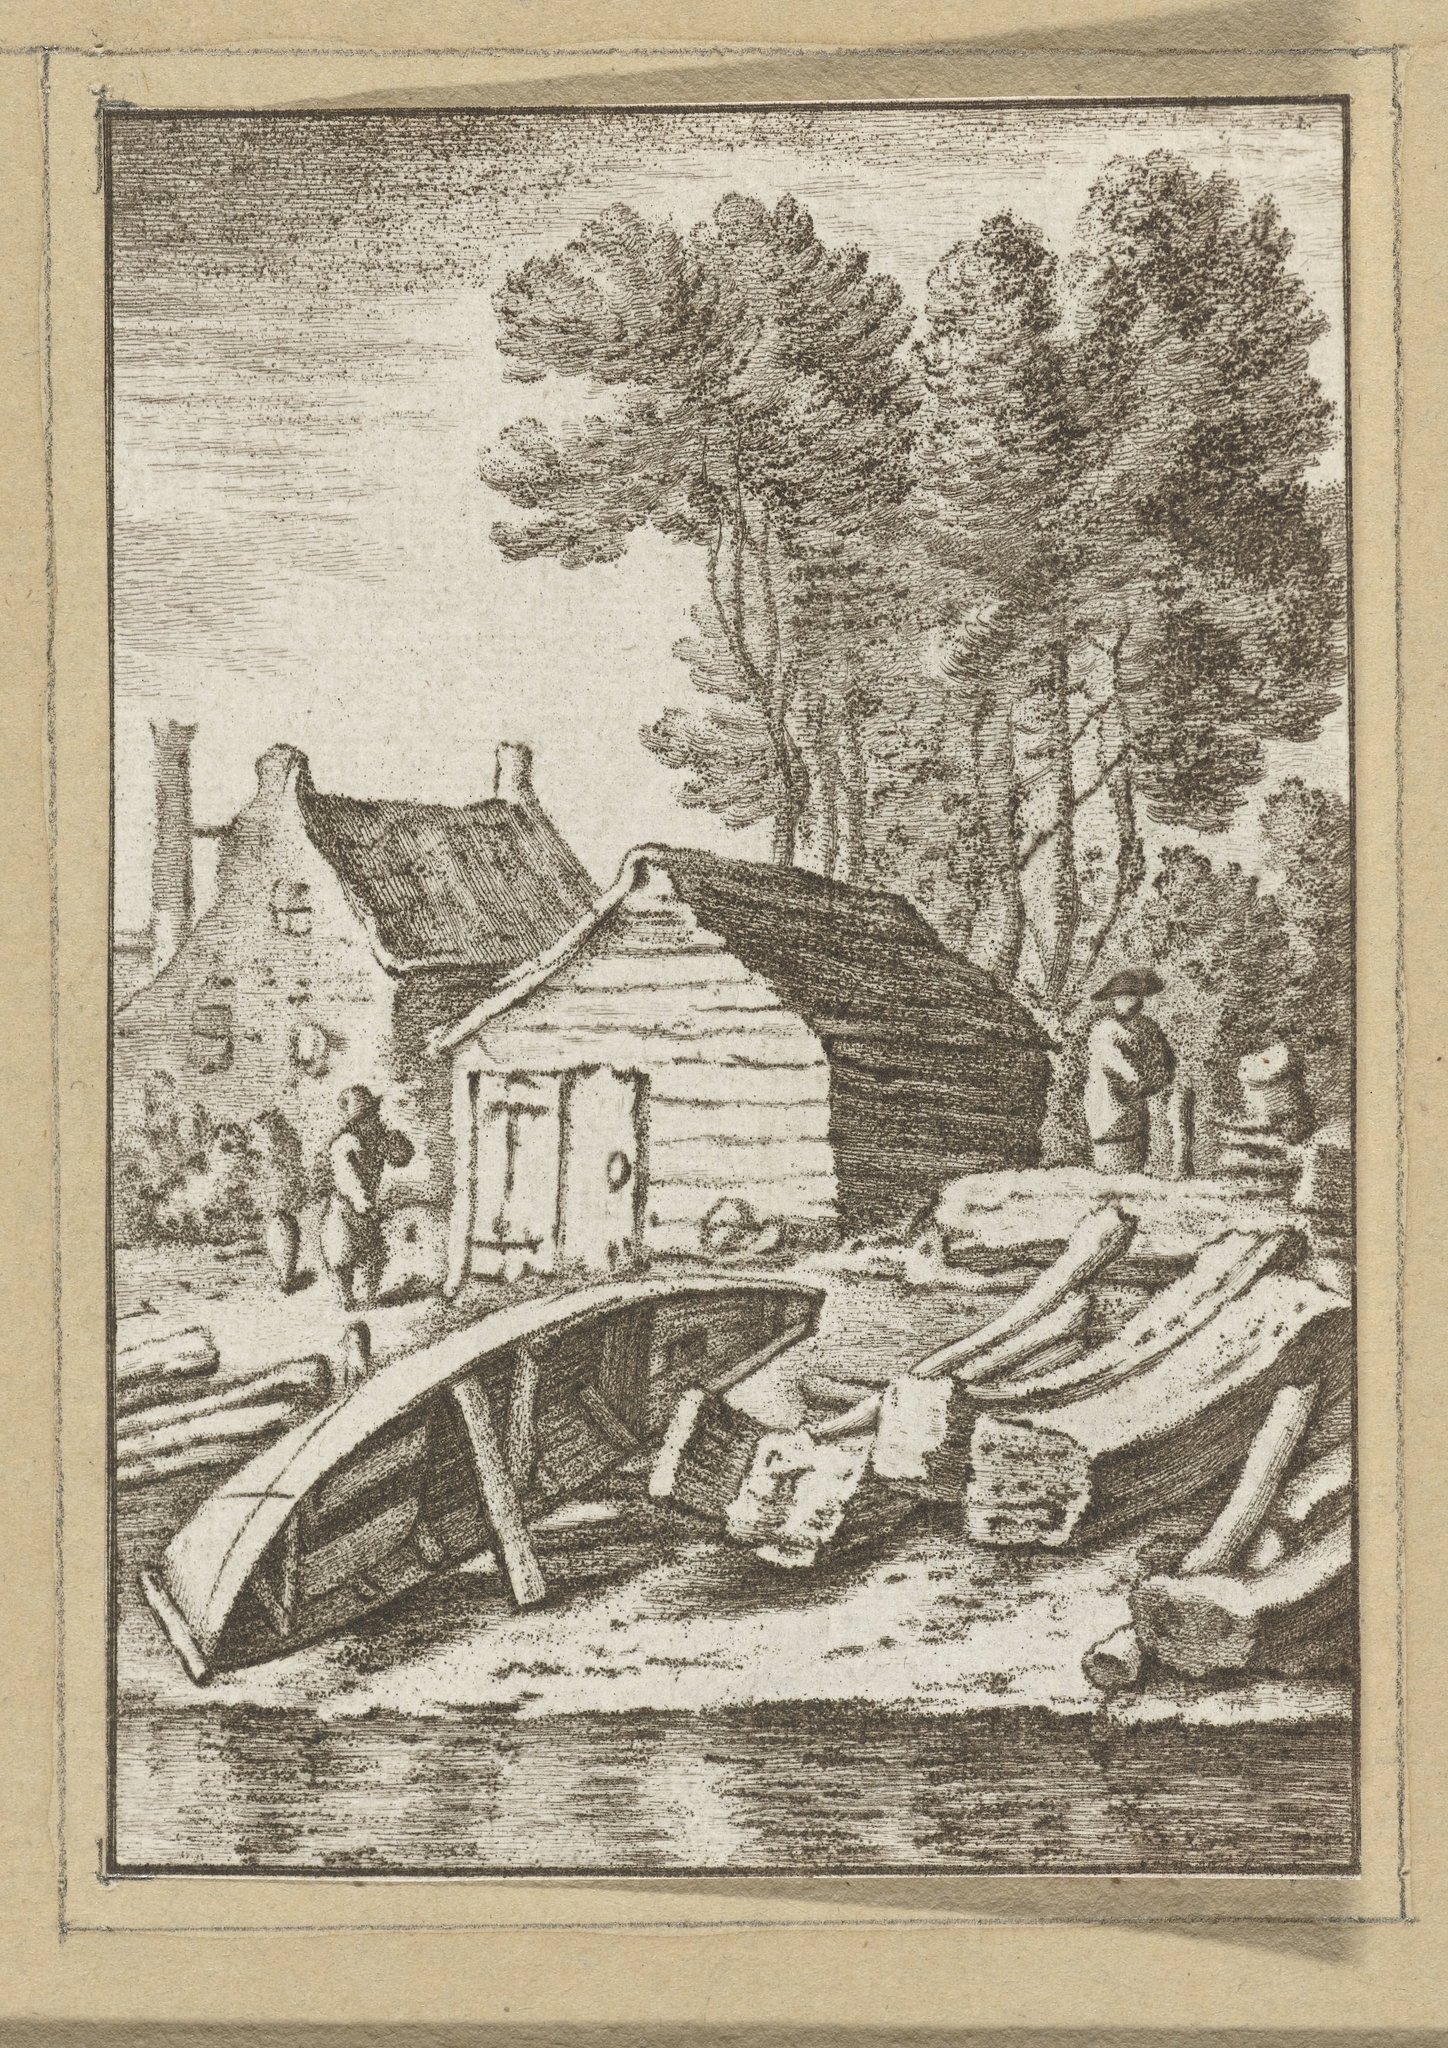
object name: print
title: Prentwerk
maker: cornelis ploos van amstel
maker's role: draughtsman, print maker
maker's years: 1726-1798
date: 1761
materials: paper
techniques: printmaking, etching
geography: amsterdam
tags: shipyard, shipdock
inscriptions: collector's mark: Lugt 12, collector's mark: Lugt 2725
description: Een scheepswerf met enkele figuren, een huis en een schuur.